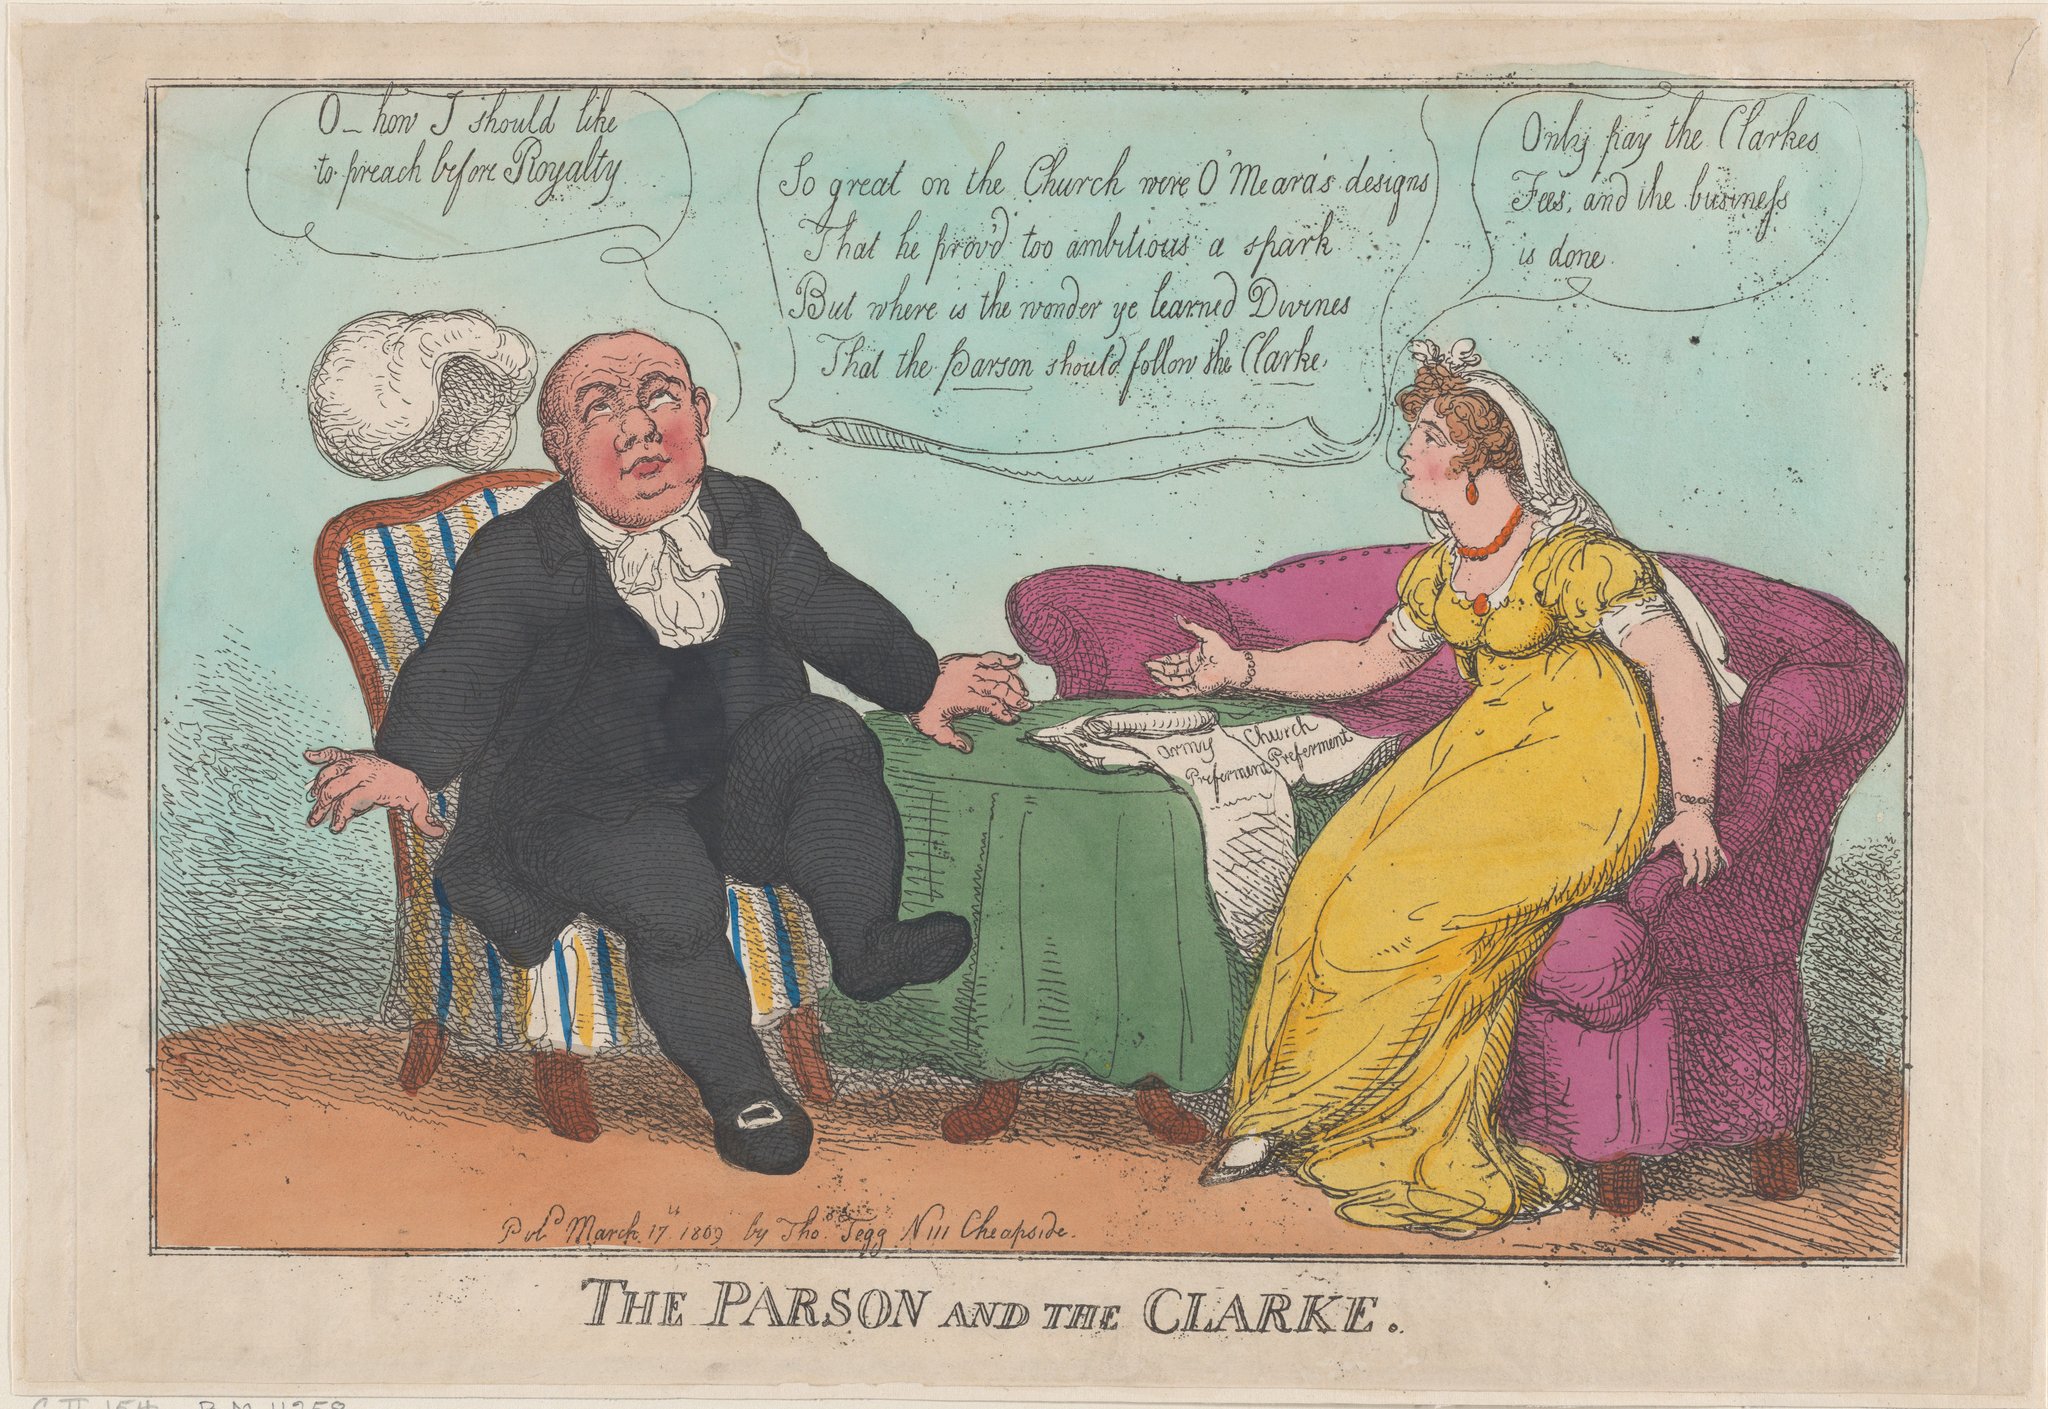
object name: print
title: The Parson [Reverend O'Meara] and the Clarke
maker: thomas rowlandson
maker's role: artist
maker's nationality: british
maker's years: 1757-1827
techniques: etching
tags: satire,men,women,politics